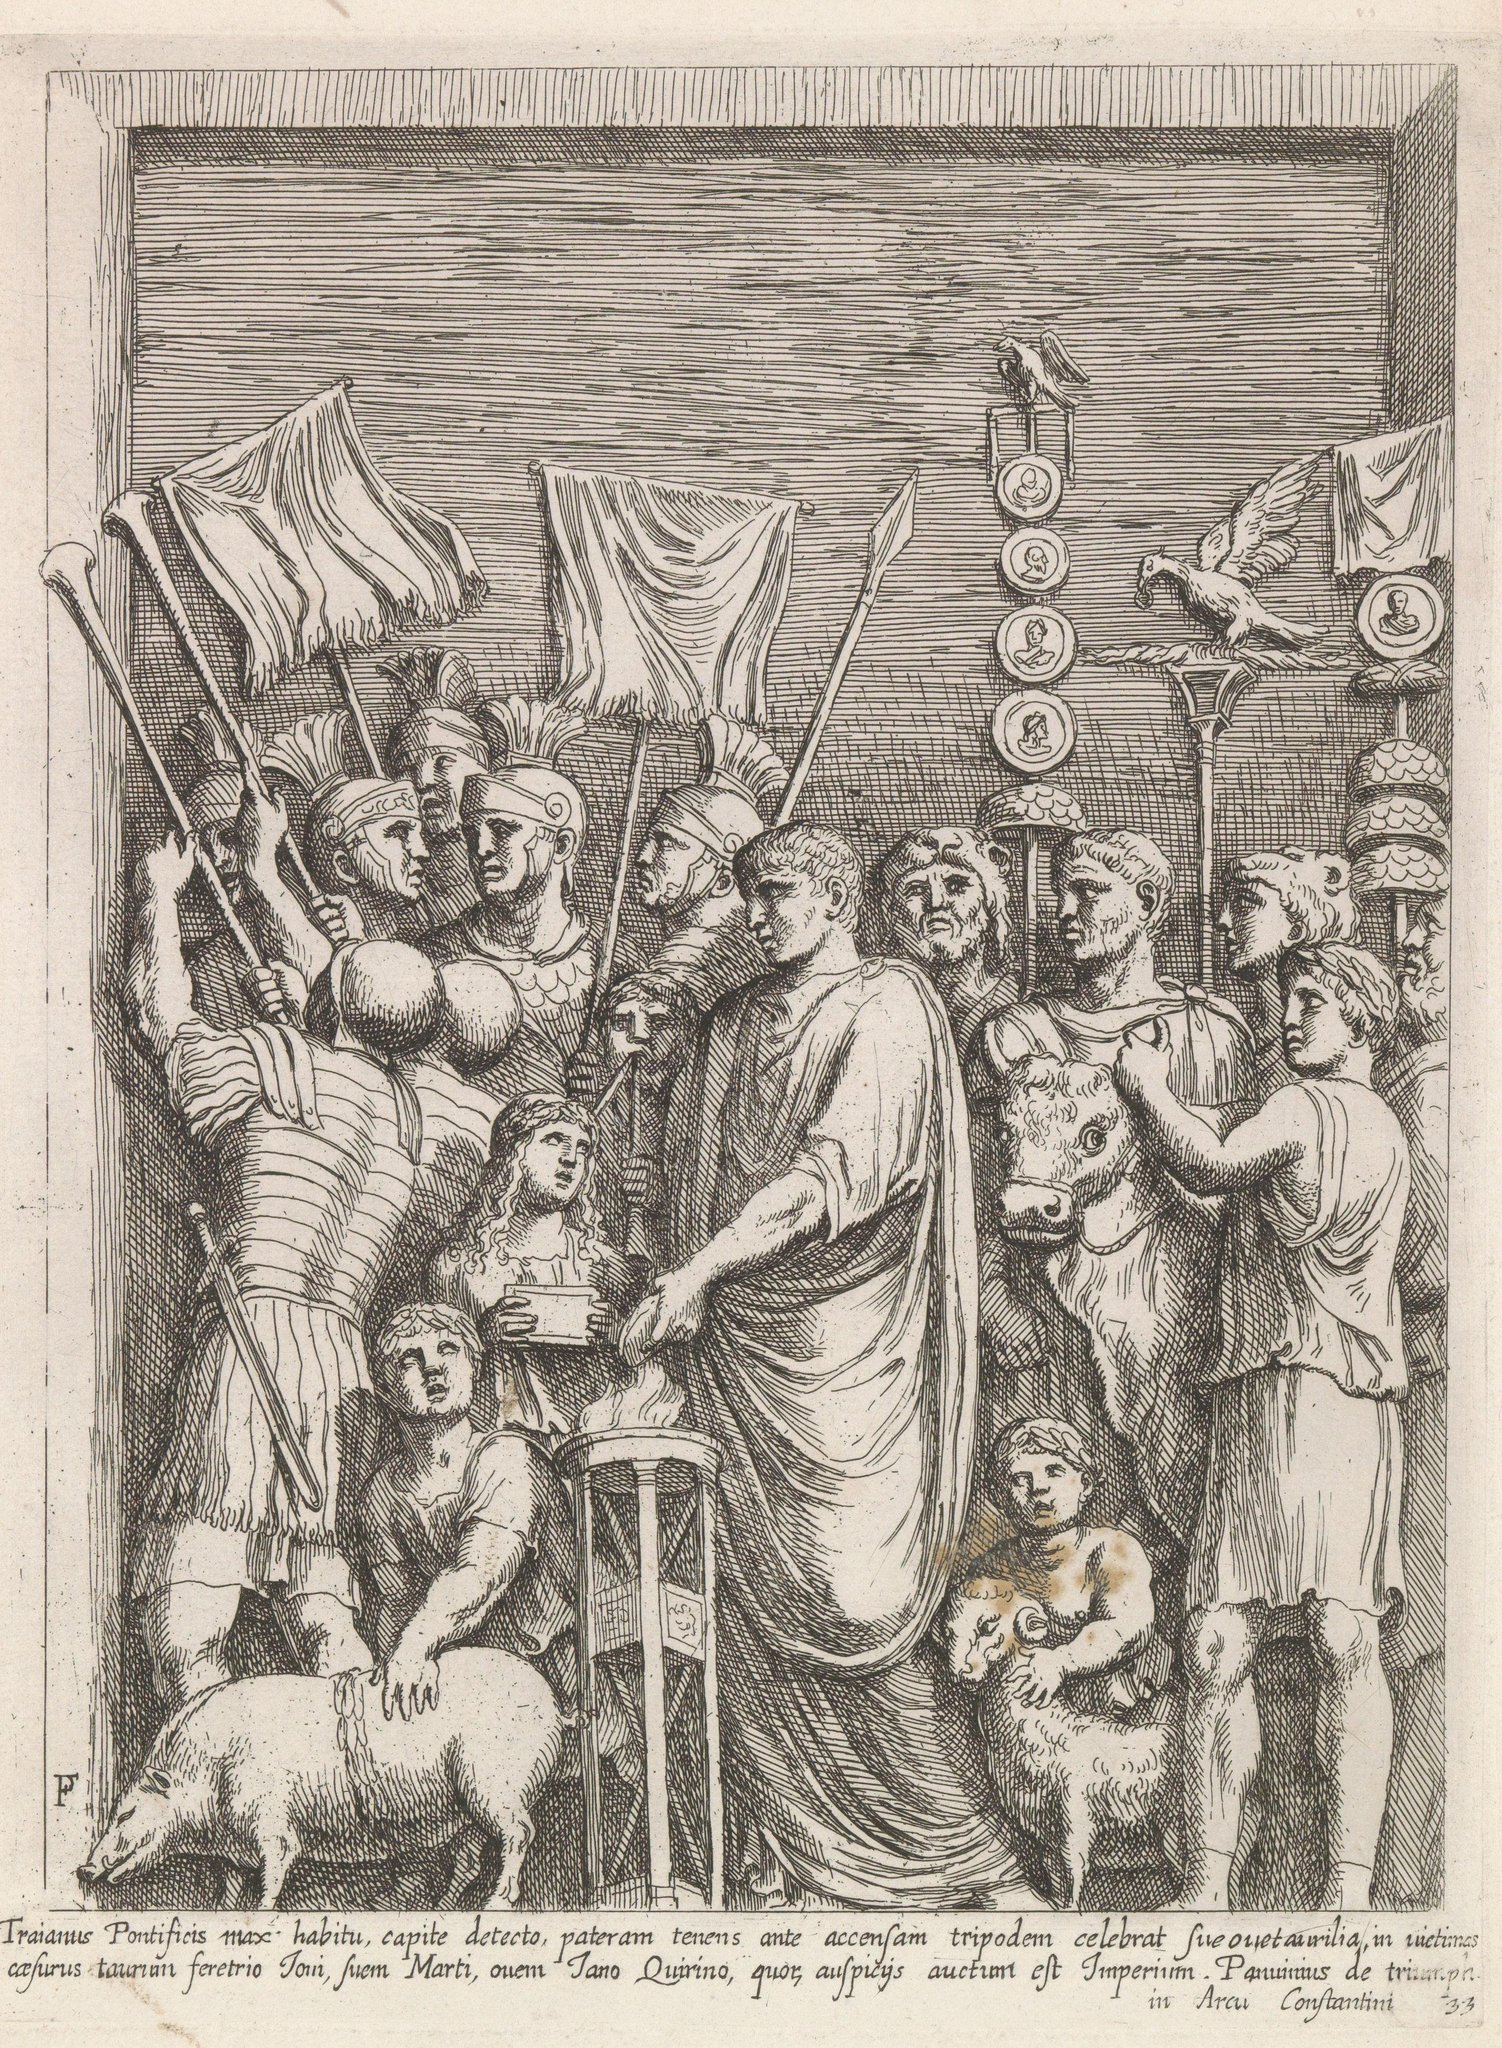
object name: album leaf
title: Romeinse gebeeldhouwde reliëfs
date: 1645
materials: paper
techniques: etching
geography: paris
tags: animal sacrifice ~ roman religion, piece of sculpture, reproduction of a piece of sculpture, the soldier; the soldier's life, ruler, sovereign, arch of constantine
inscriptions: inscription: ‘Ende lib. No. 5. fol. 64. 65.’, number: ‘60’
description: Deze prent maakt deel uit van een reeks van 54 prenten (+ titelprent) naar antieke reliëfs. De nummering op de prenten loopt van 1 tot en met 50. Sommige prenten hebben dubbele nummers. Naar de reliëfs op de Boog van Constantijn te Rome.